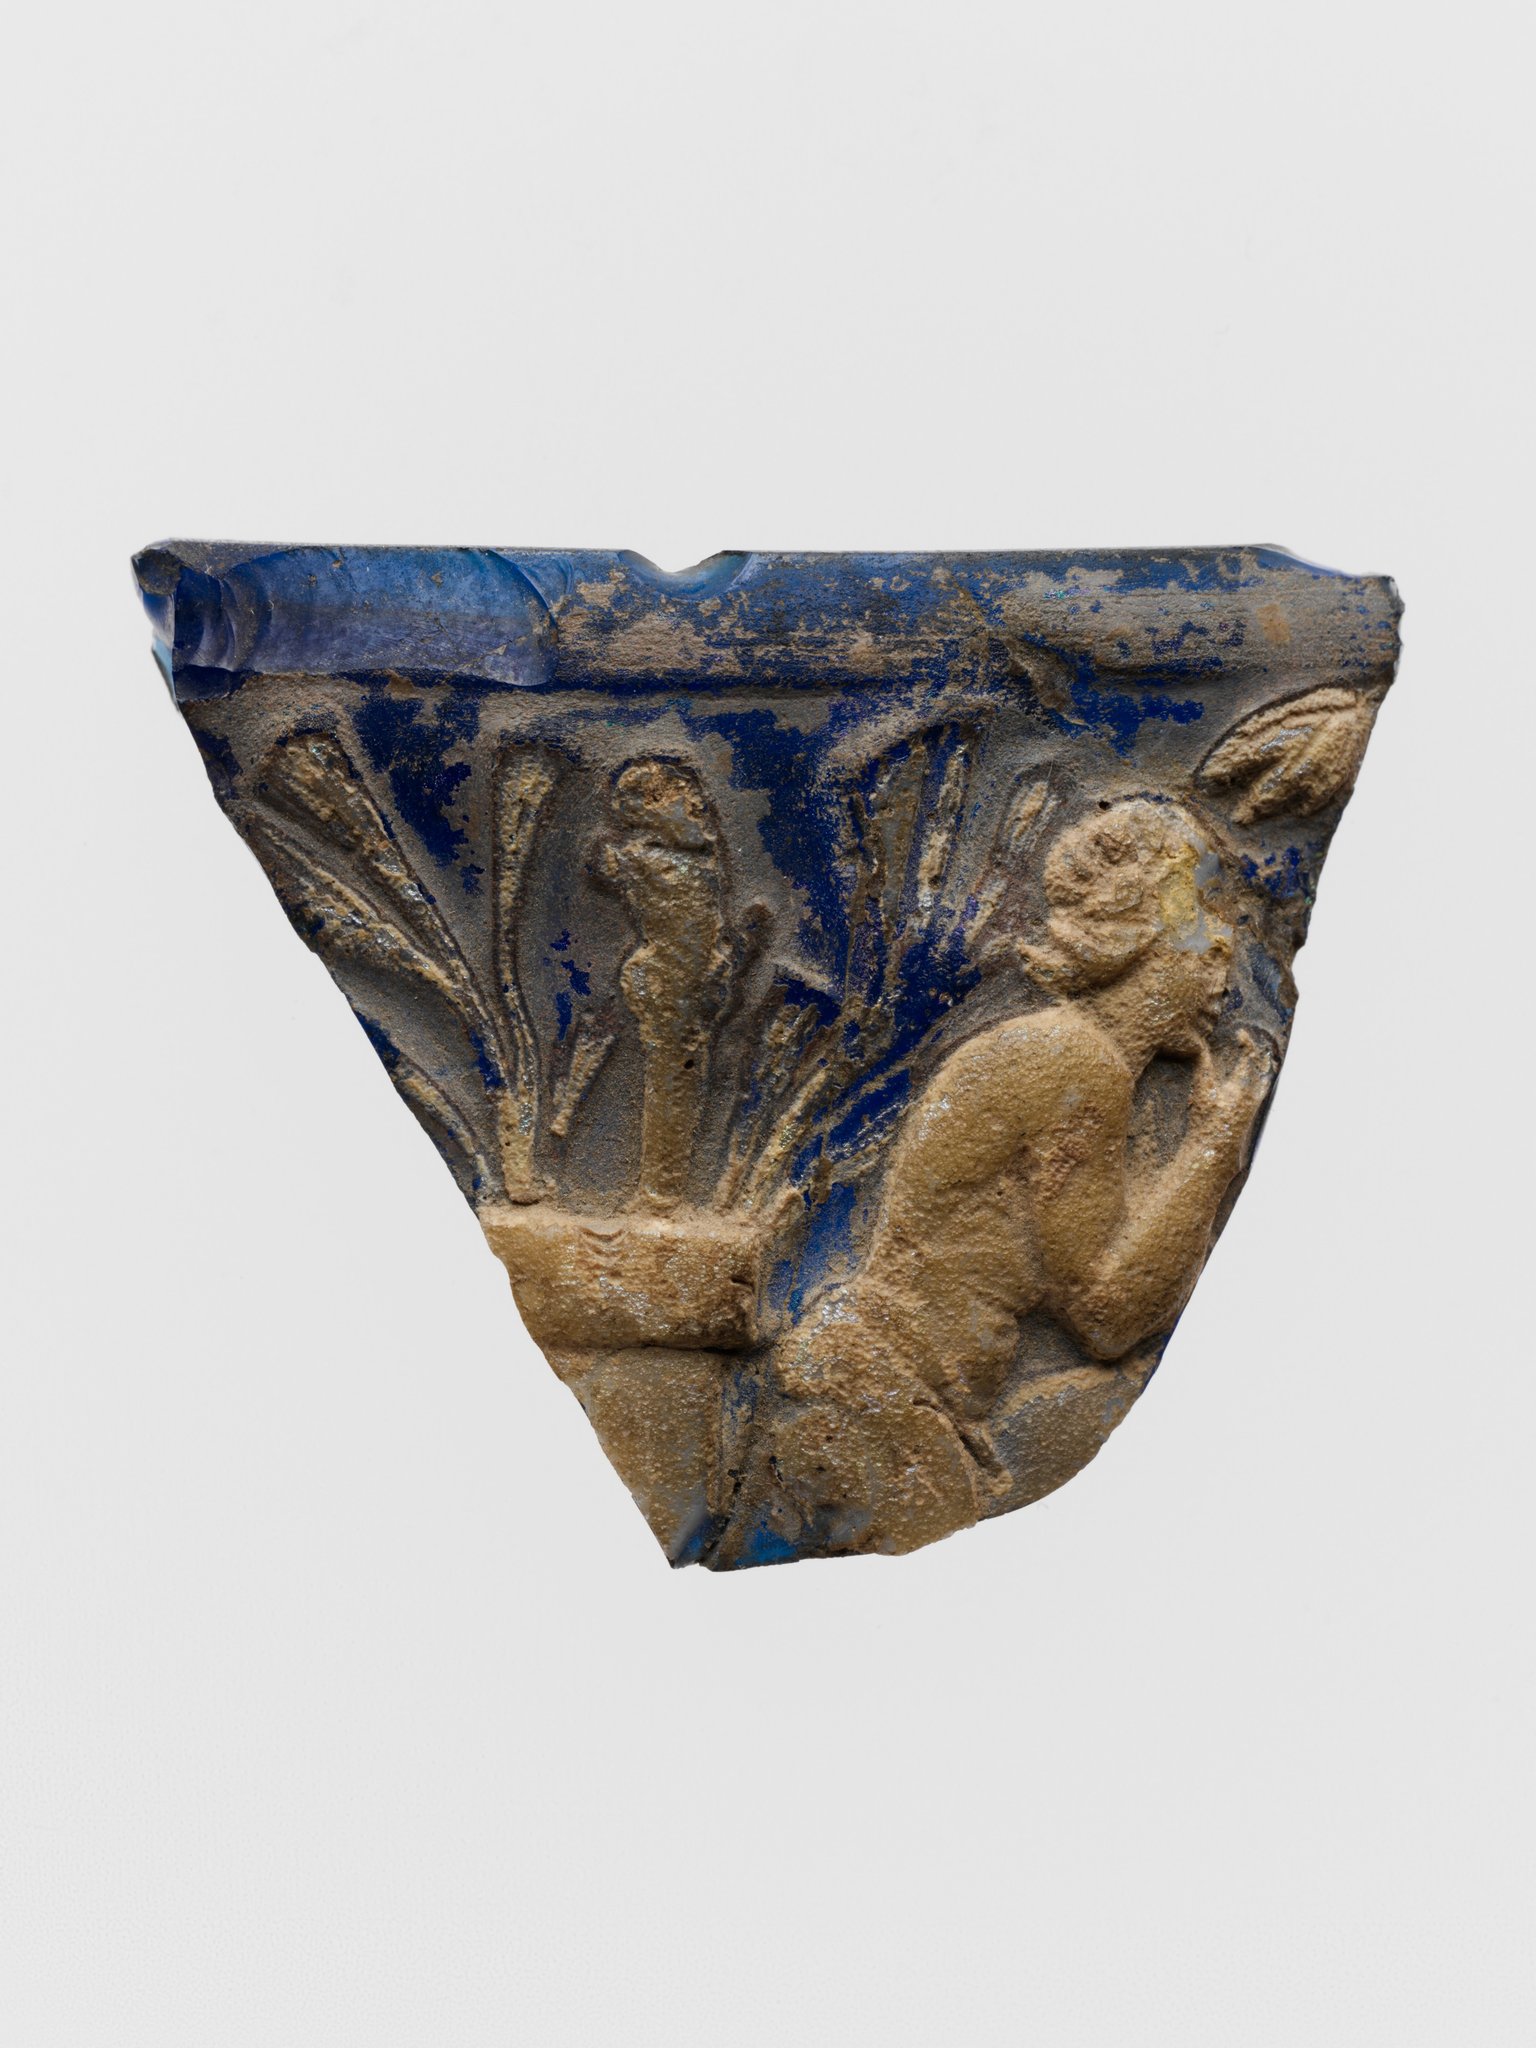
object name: cameo, fragment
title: Cameo-glass cup fragment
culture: roman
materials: glass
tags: silenus,satyrs